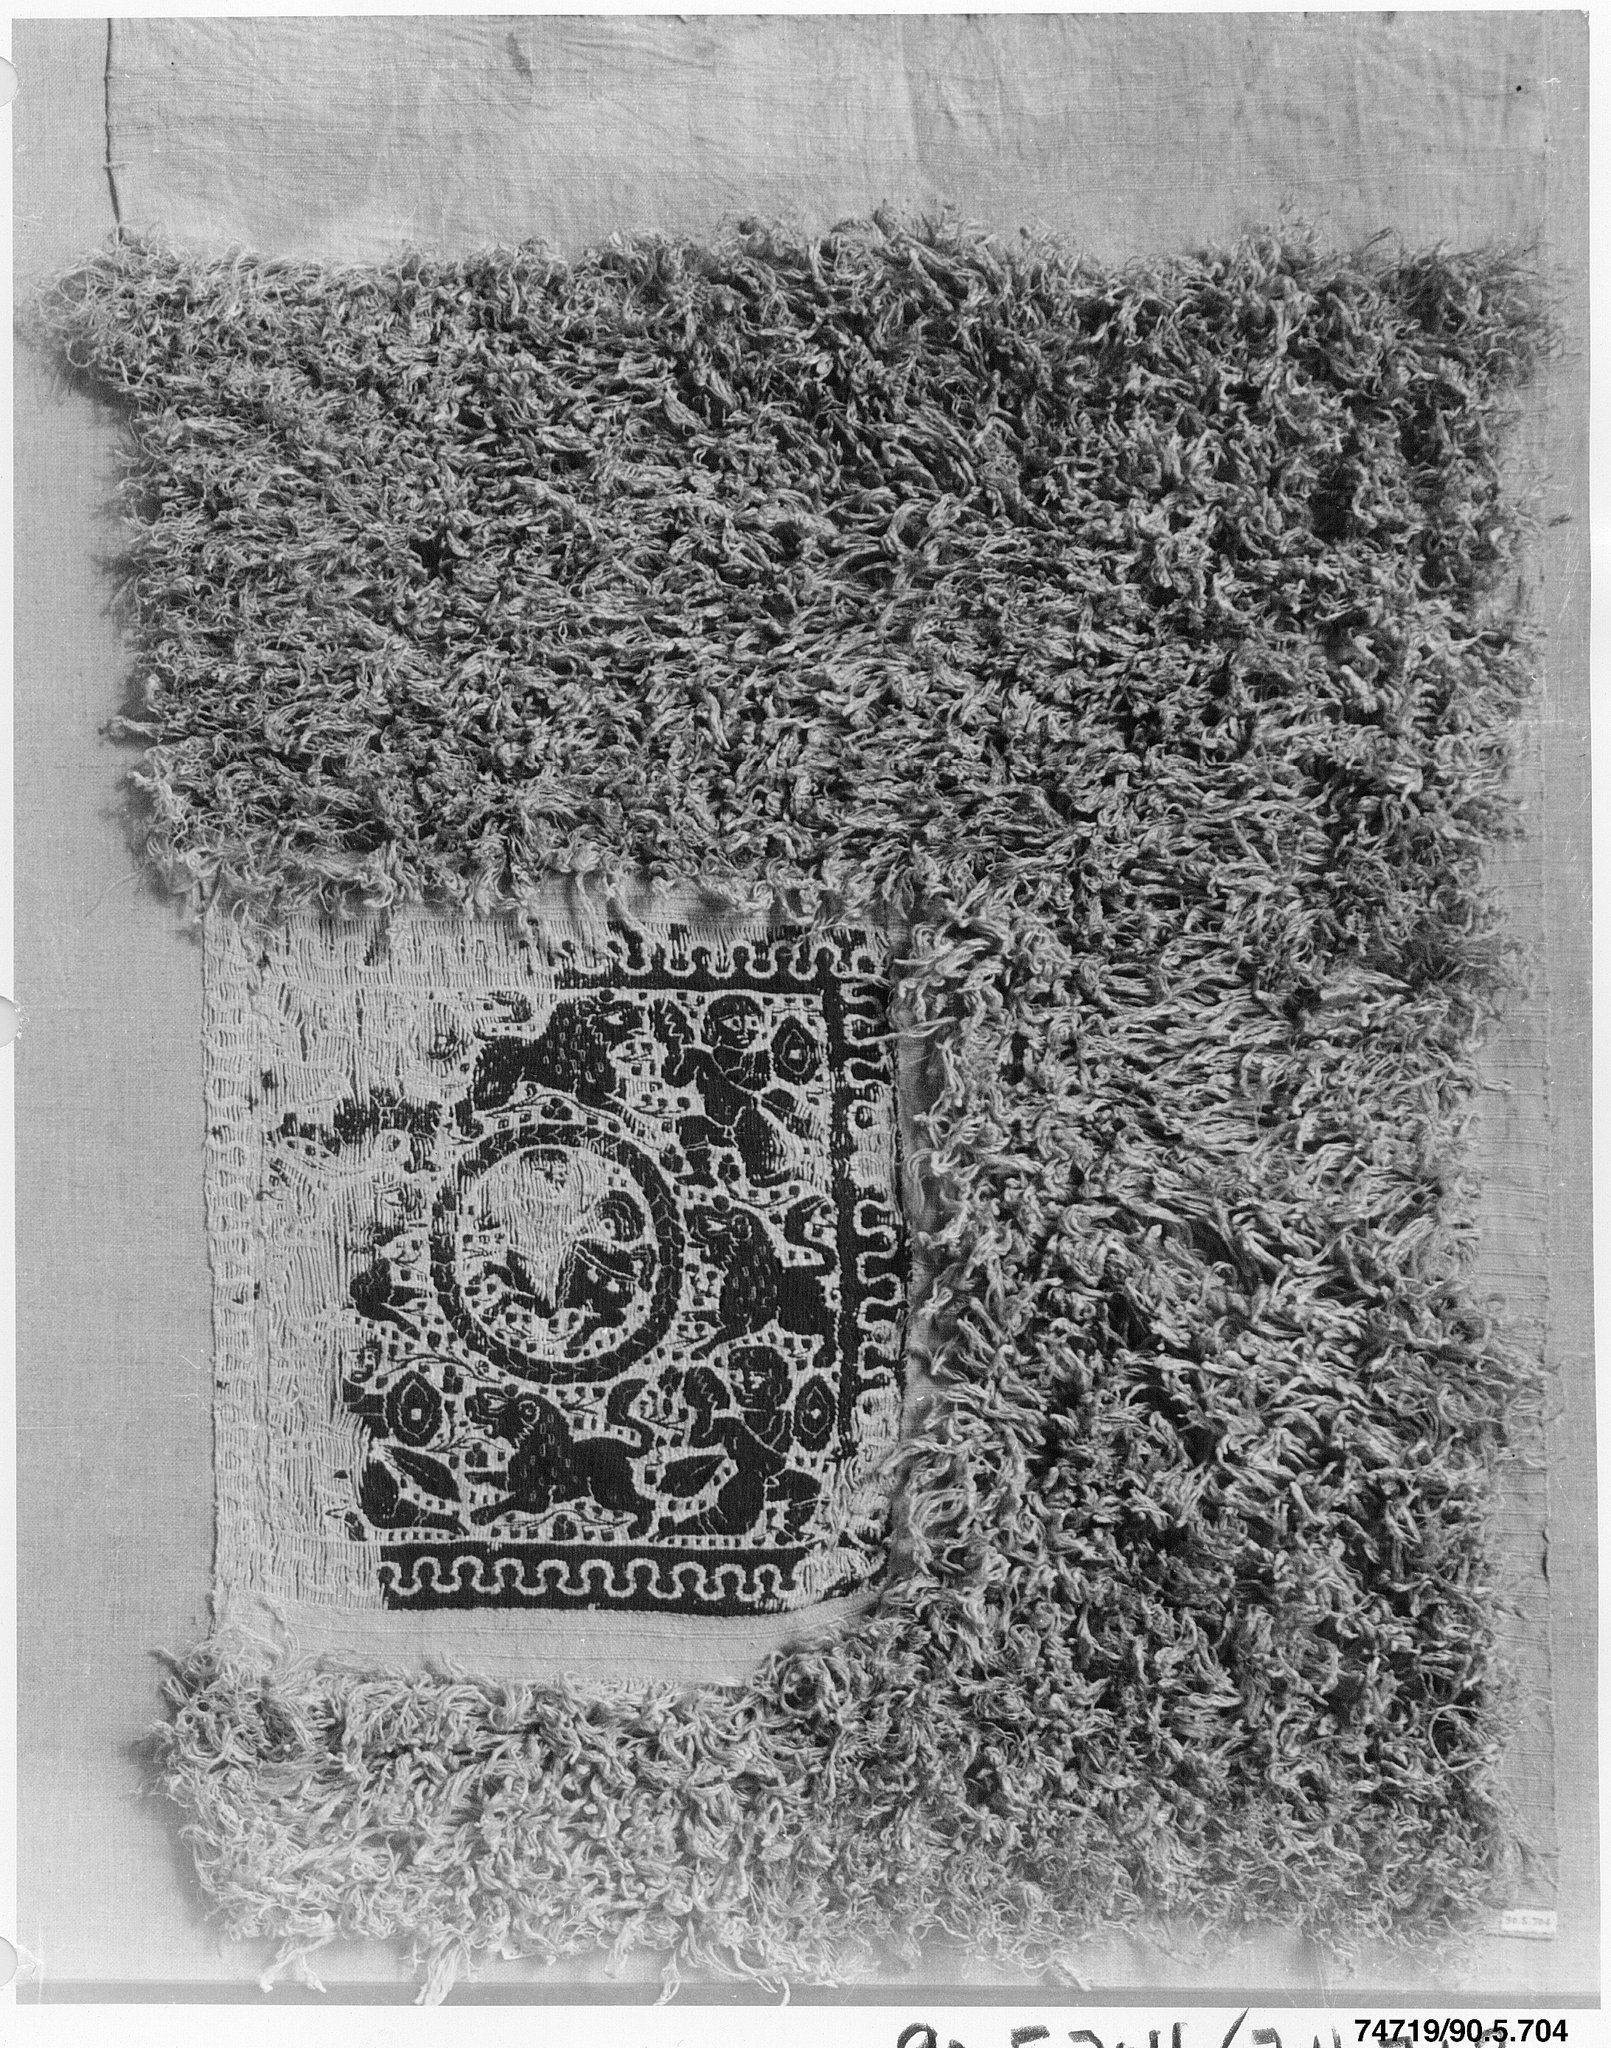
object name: textile fragment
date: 301-400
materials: linen, wool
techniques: weave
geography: egypt